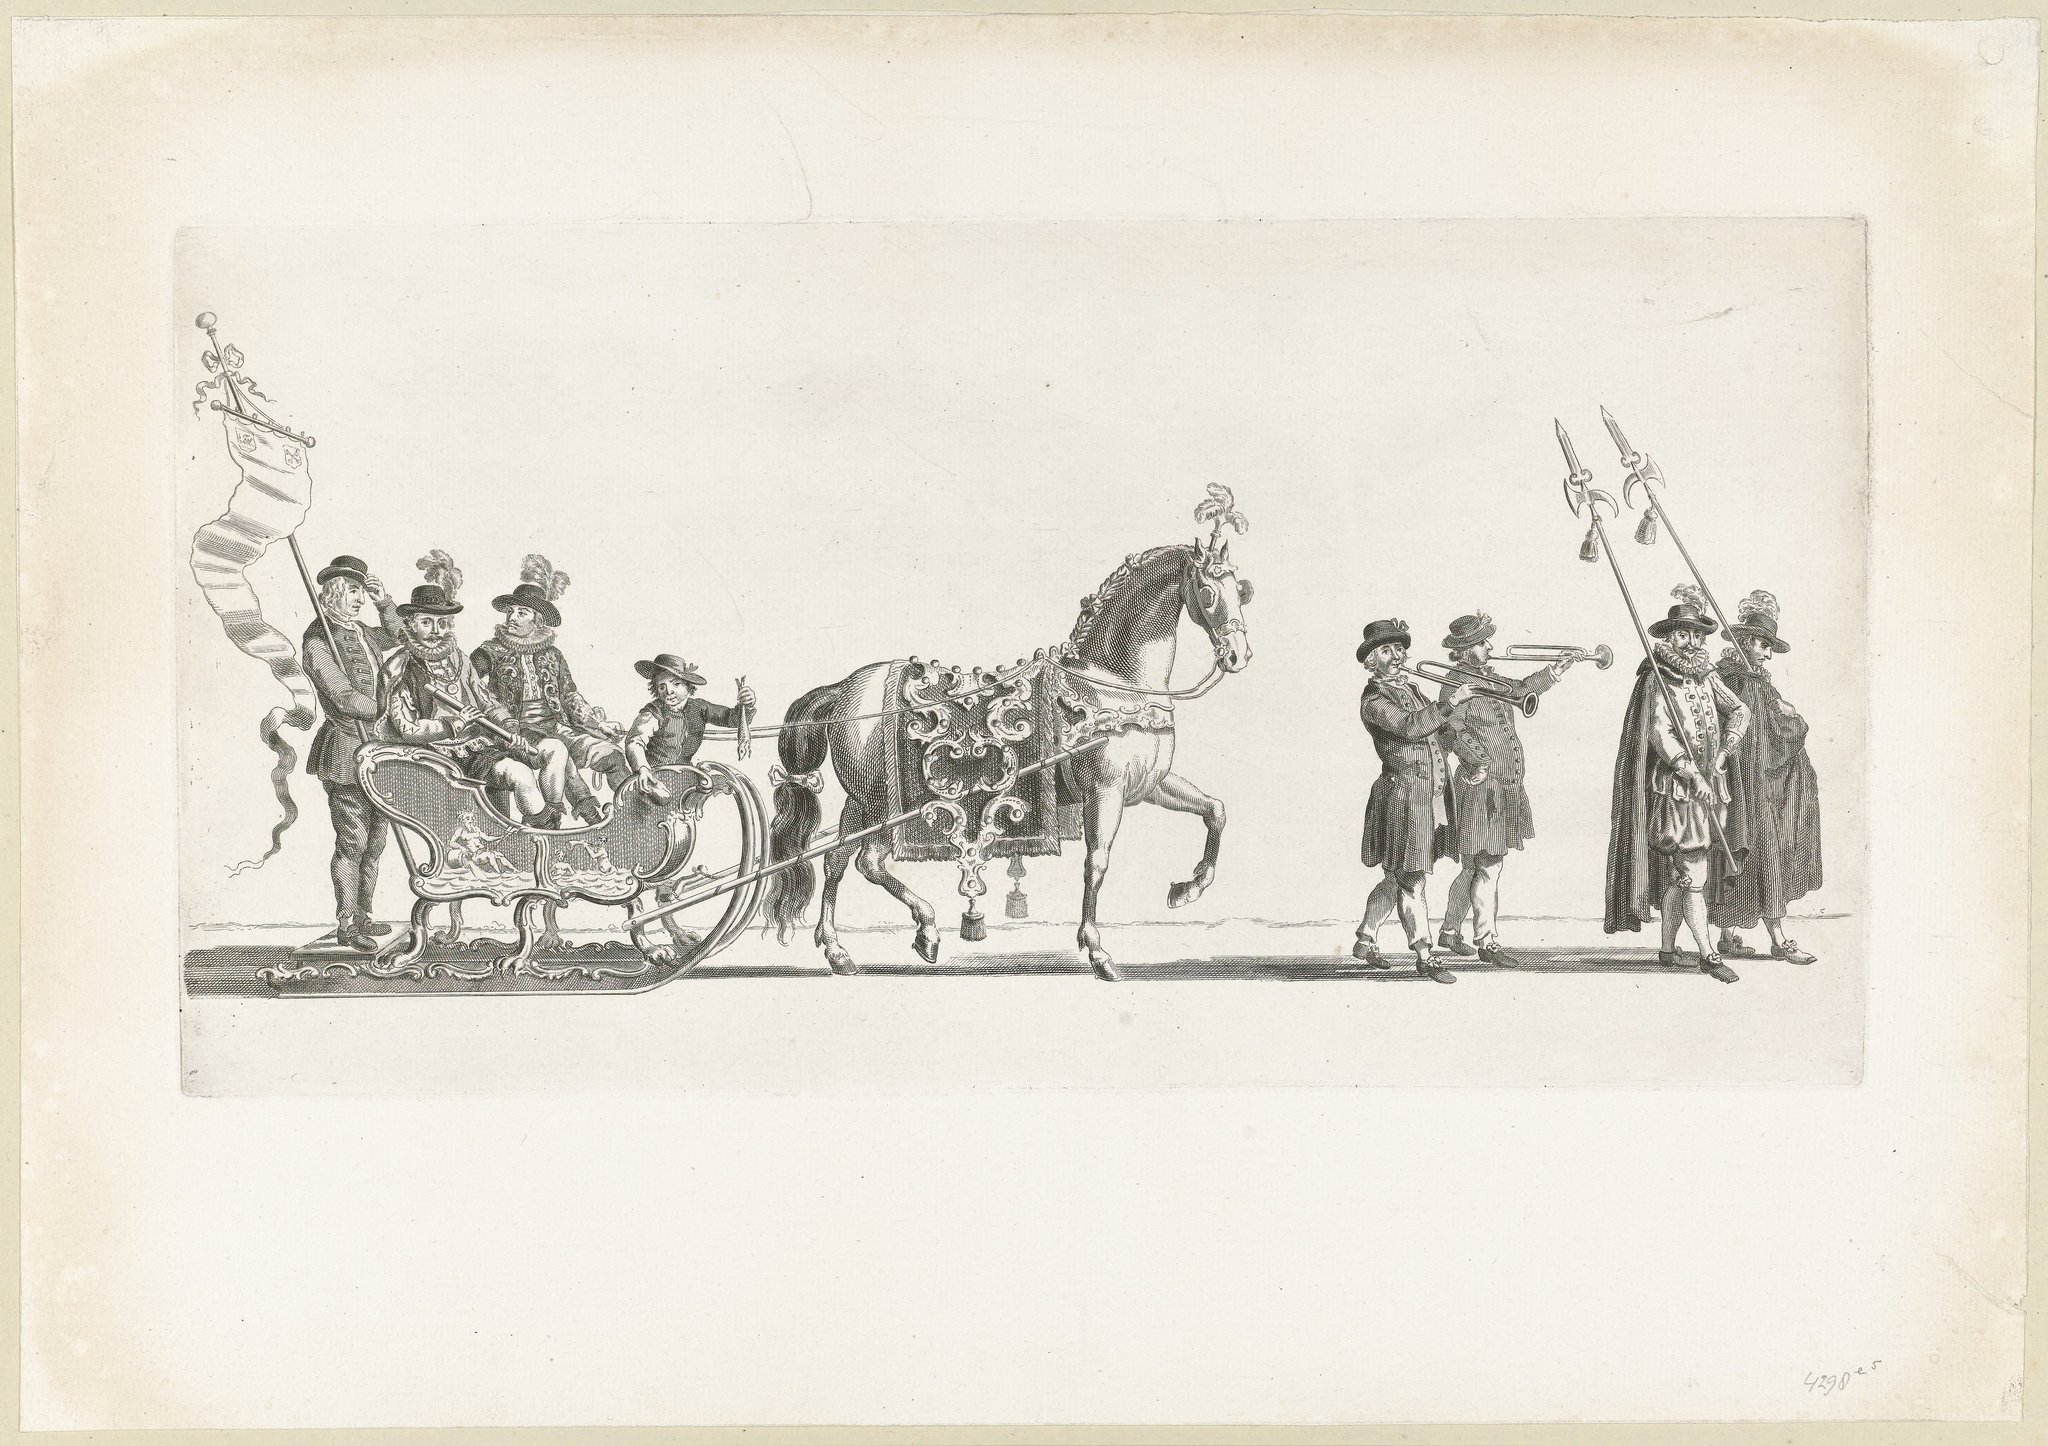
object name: print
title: Vijfde slede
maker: nicolaas van der worm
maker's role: draughtsman, print maker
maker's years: 1757-1828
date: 1776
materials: paper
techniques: engraving, etching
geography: northern netherlands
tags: brussels, sledge, sleigh (winter sports), commemoration of the founding of a university, leiden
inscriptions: inscription: ‘afgemaekte Proefdruk / N vd worm’, collector's mark: Lugt 240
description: De vijfde slede in de optocht. Een slede met Louis de Boisot en een jongen met witbrood en een haring, getrokken door een paard en voorafgegaan door twee muzikanten en twee hellebaardiers. Onderdeel van een reeks van twaalf platen (vóór het nummer en op ander papier) van de sledevaart op 24 januari 1776 georganiseerd door het Leidse genootschap Veniam Pro Laude bij gelegenheid van het Tweede Eeuwfeest van het Leids Ontzet (3 oktober 1574) en de oprichting van de Universiteit van Leiden (8 februari 1575).